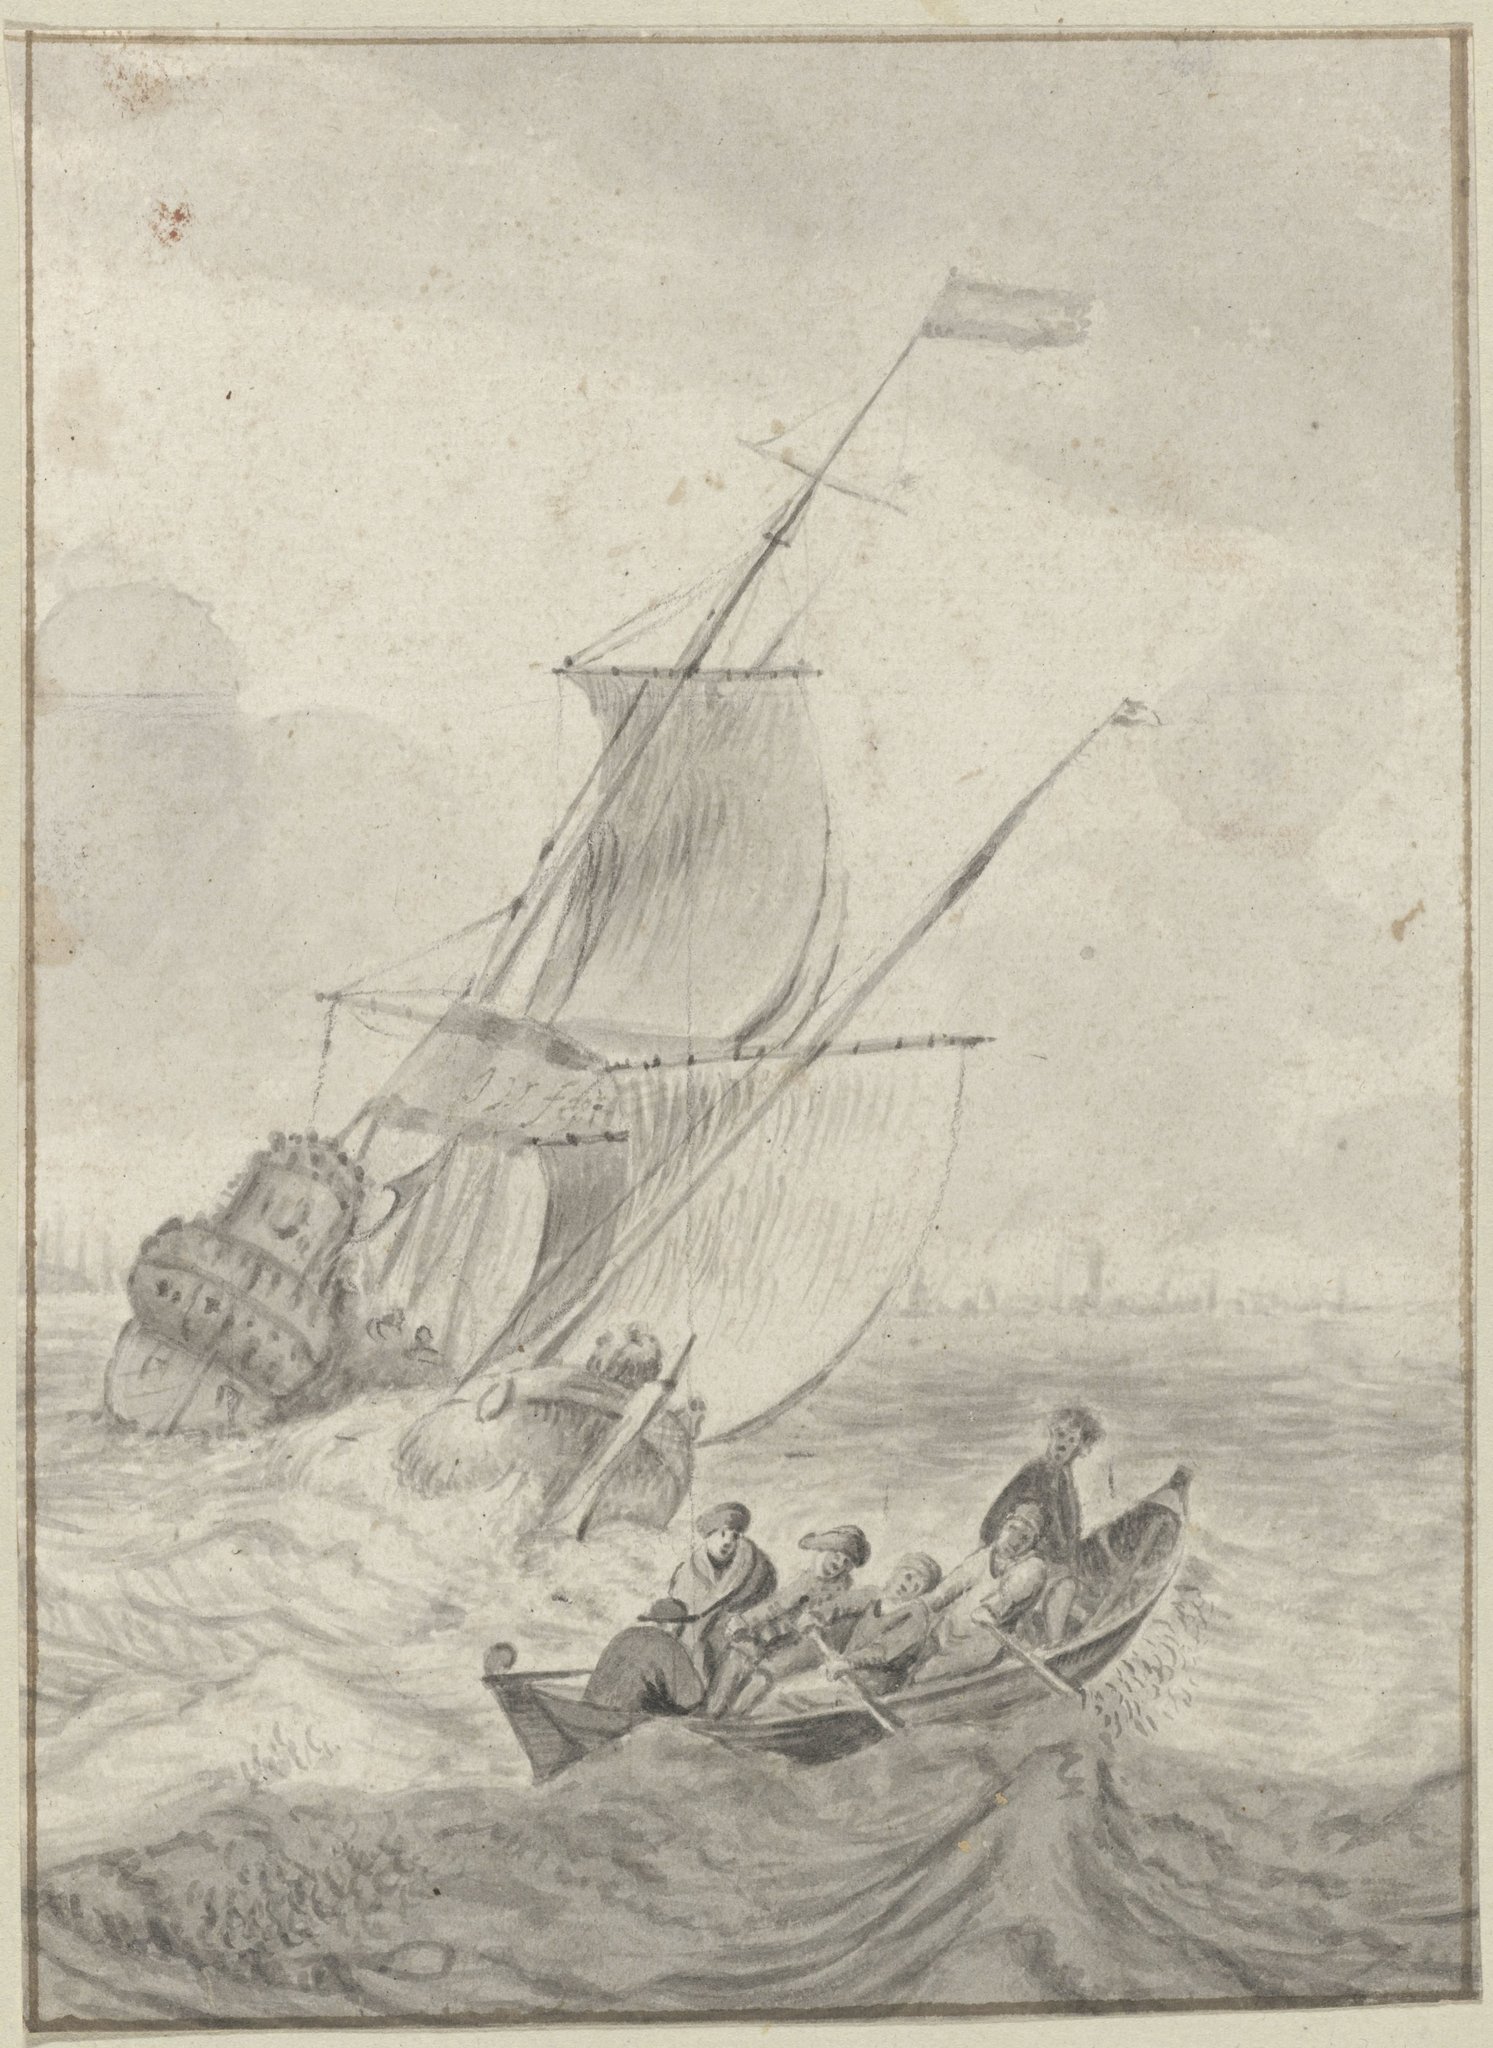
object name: drawing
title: Twee zeilschepen en een roeiboot in stormachtig weer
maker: Anonymous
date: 1650-1799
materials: ink, paper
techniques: brush, pen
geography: netherlands